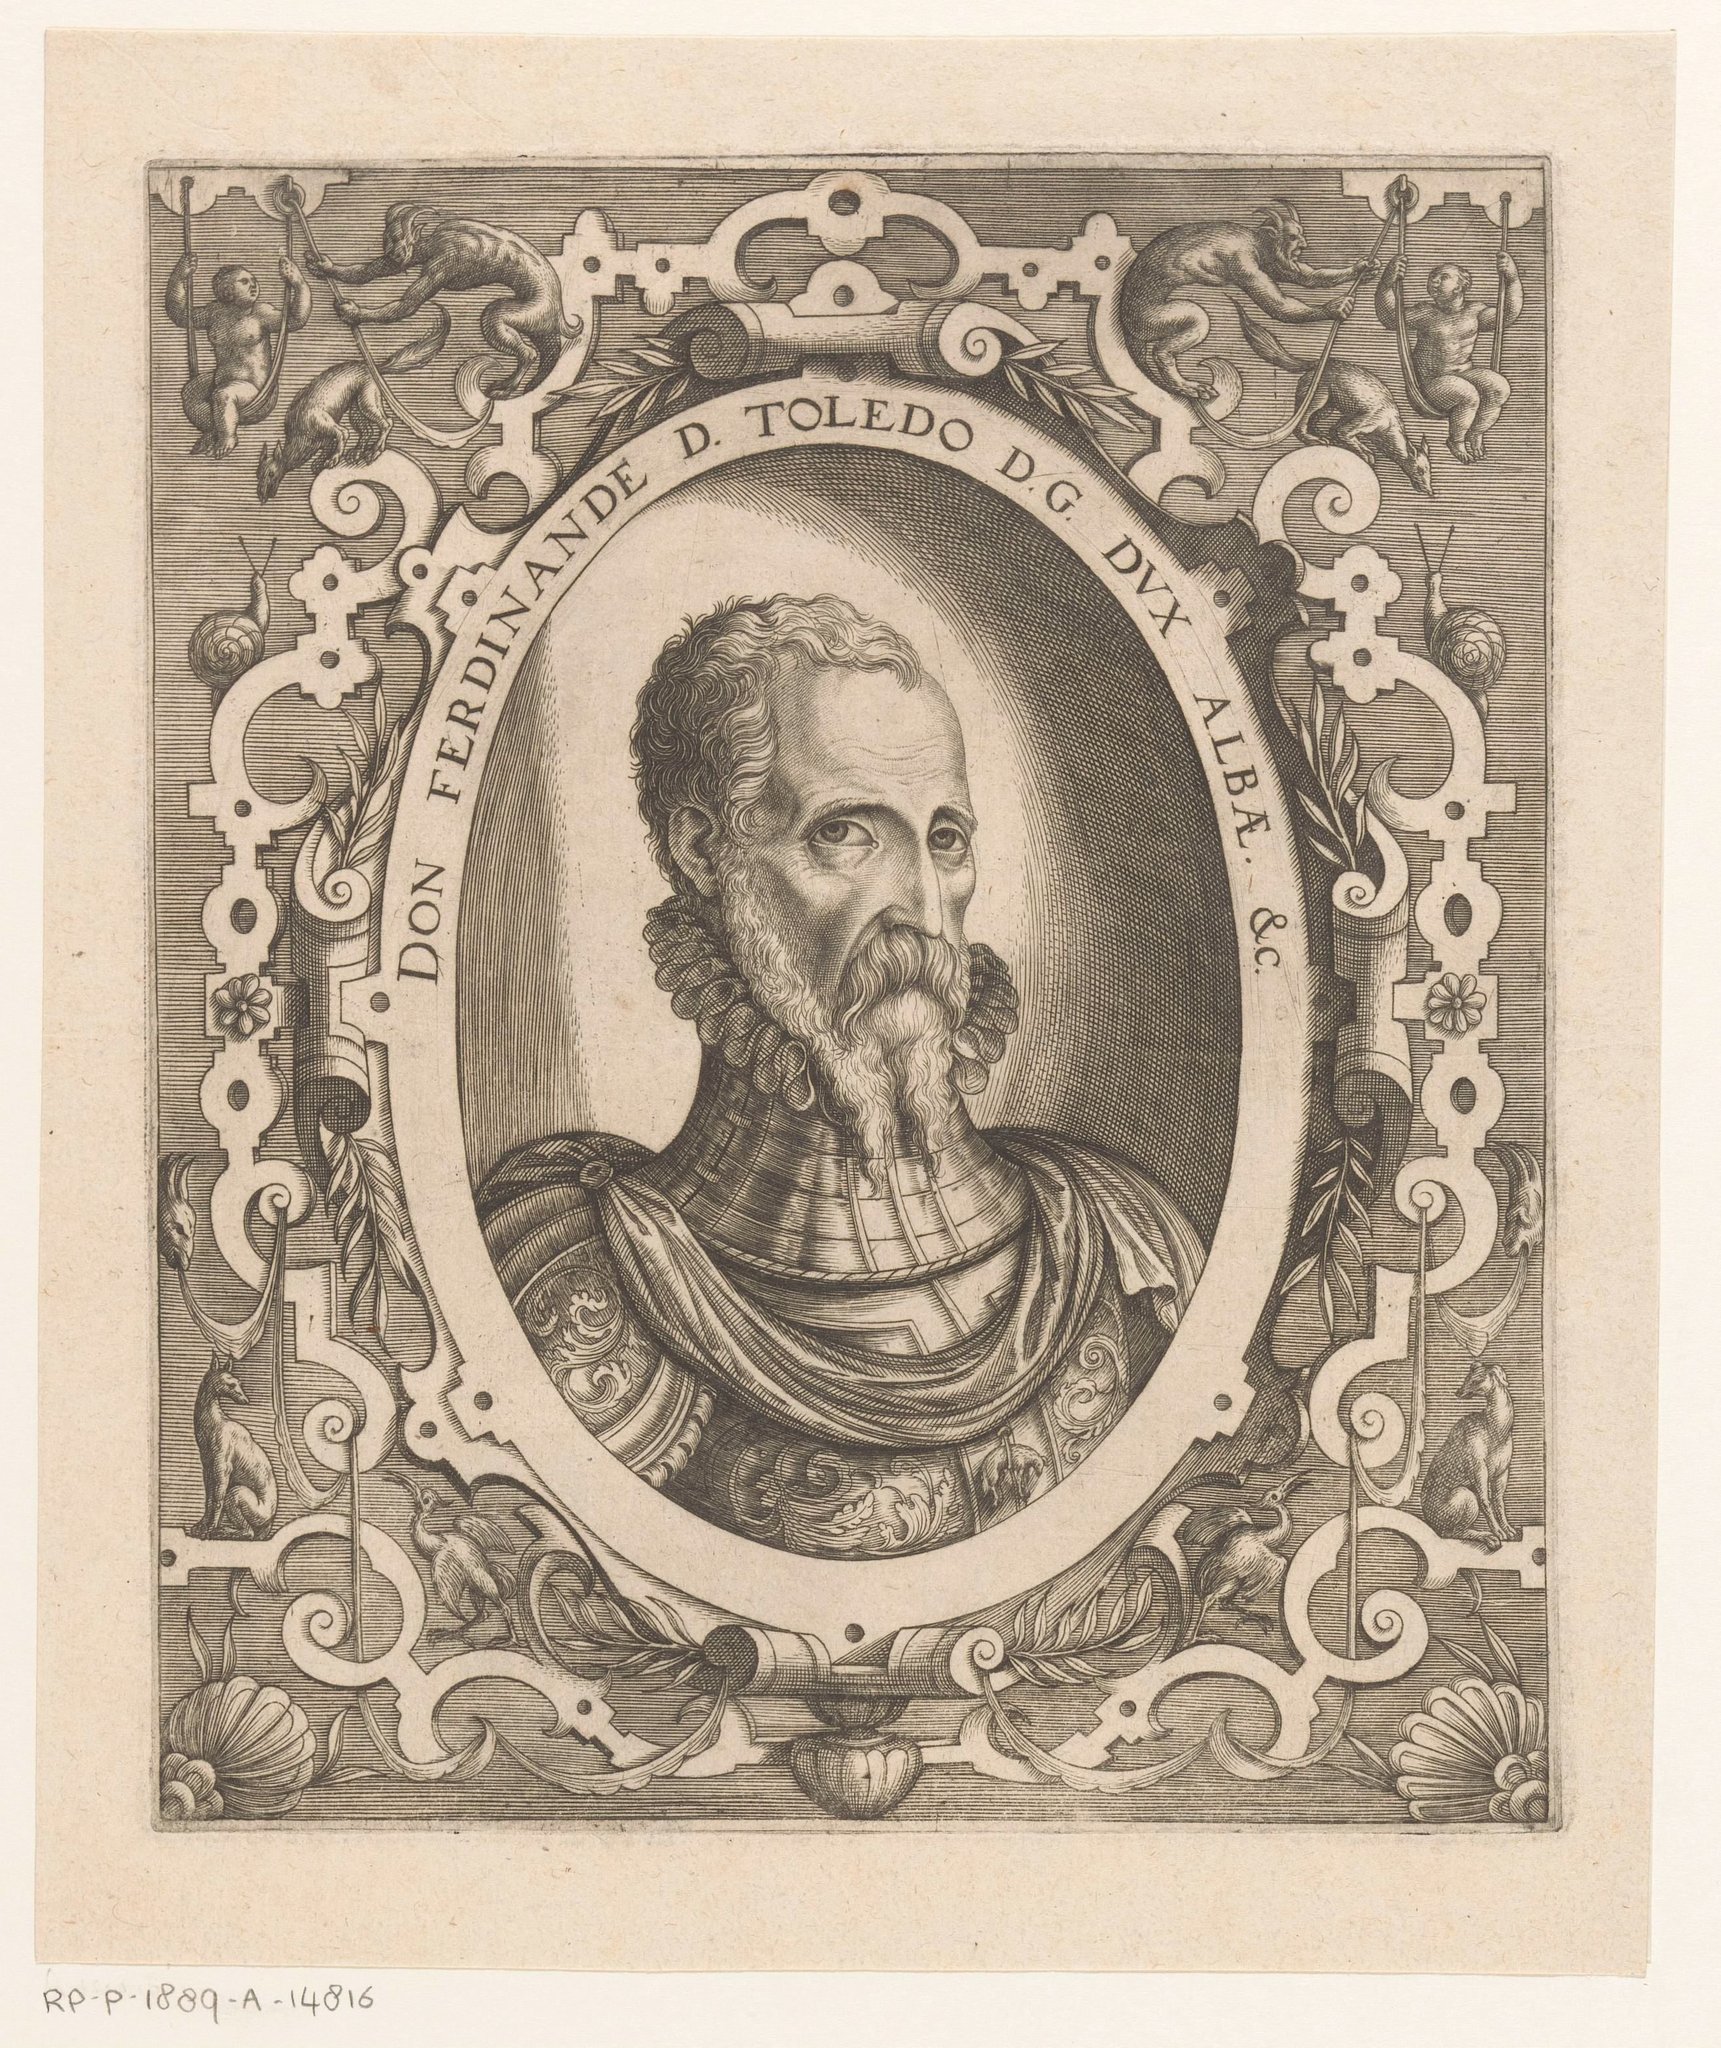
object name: print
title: Portret van Fernando Álvarez de Toledo, hertog van Alva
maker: niccolò nelli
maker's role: print maker, publisher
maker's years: 1535-1585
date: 1569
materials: paper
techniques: engraving, etching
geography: venice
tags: fernando álvarez de toledo (3rd duke of alba), ornament derived from animal forms, fruits and vegetables ~ ornament, historical persons, knighthood order of the golden fleece - insignia of a knighthood order, e.g.: badge, chain (with name of order)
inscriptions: collector's mark: Lugt 2228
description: Prent uit een serie portretten van onbekende omvang getiteld 'Imagines Quorundam Principum et Illustrium Virorum' met prenten door Niccolò Nelli, Domenico Zenoi, Martino Rota, Nicolas Bèatrizet en Cornelis Cort, uitgegeven in 1569 te Venetië.